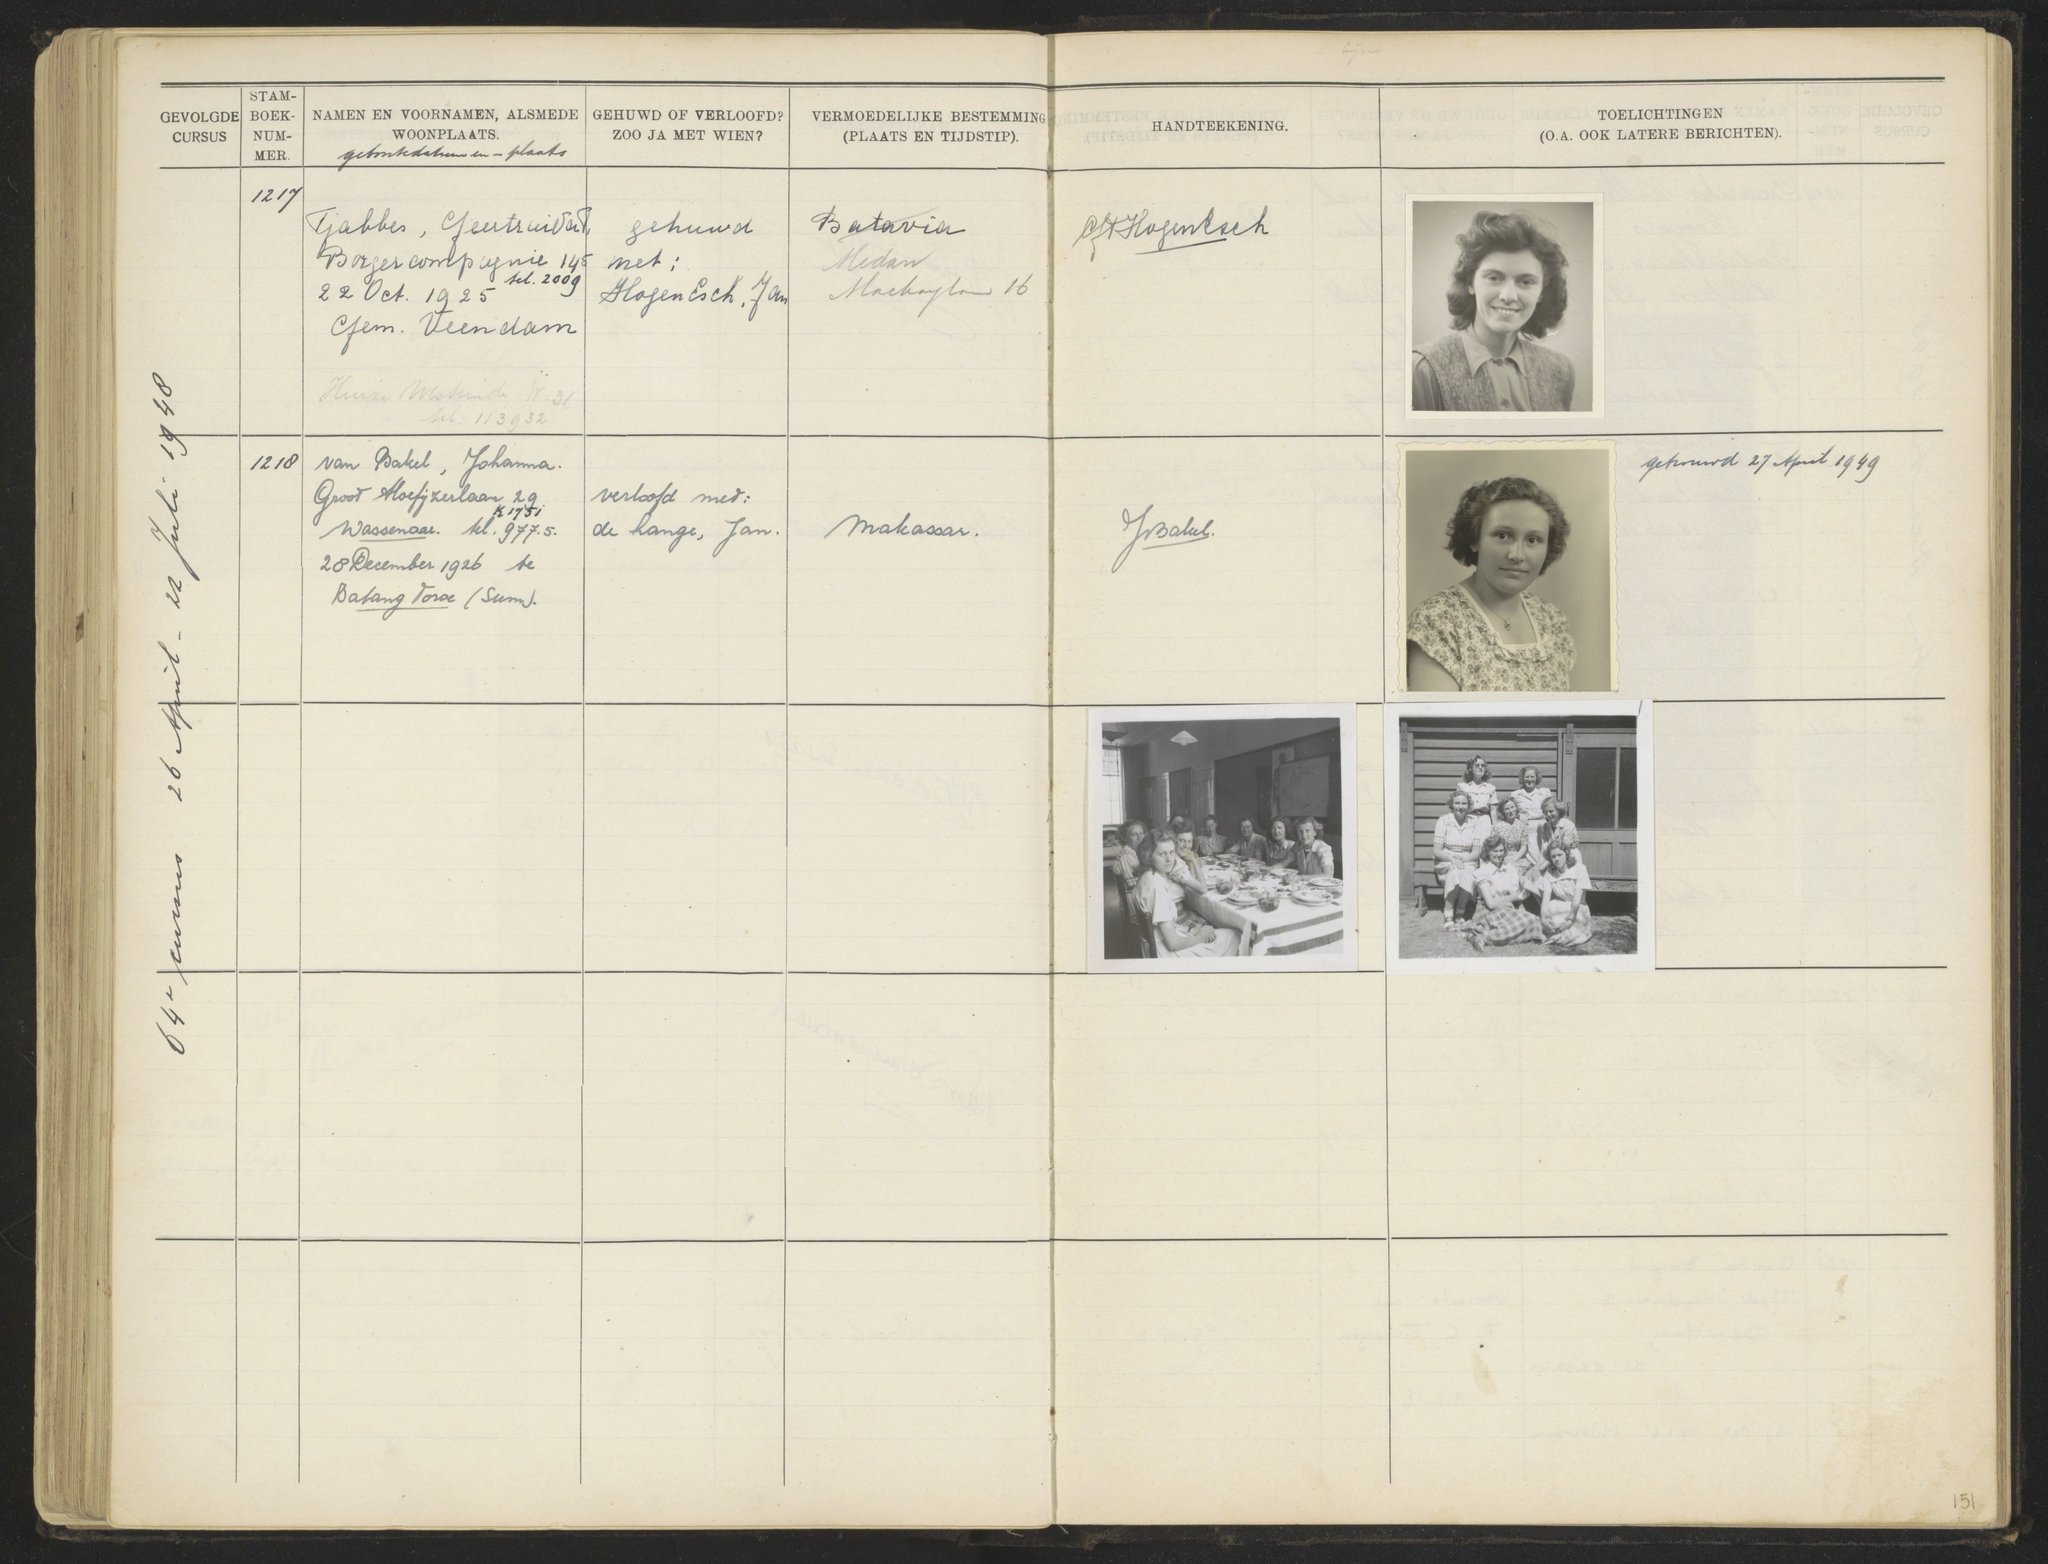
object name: album leaf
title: Blad 151 uit Stamboek van de leerlingen der Koloniale School voor Meisjes en Vrouwen te 's-Gravenhage deel II (1930-1949)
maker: Anonymous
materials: paper, photographic support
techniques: photography, printing, writing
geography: the hague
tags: further education (+ pupil), further education, the hague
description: Twee pagina's met gegevens van de deelnemers aan de 64e driemaandelijkse cursus van 26 april tot 22 juli 1948, stamboeknummers 1217 tot en met 1218. Onderdeel van Stamboek van de leerlingen der Koloniale School voor Meisjes en Vrouwen te 's-Gravenhage deel II (1930-1949).